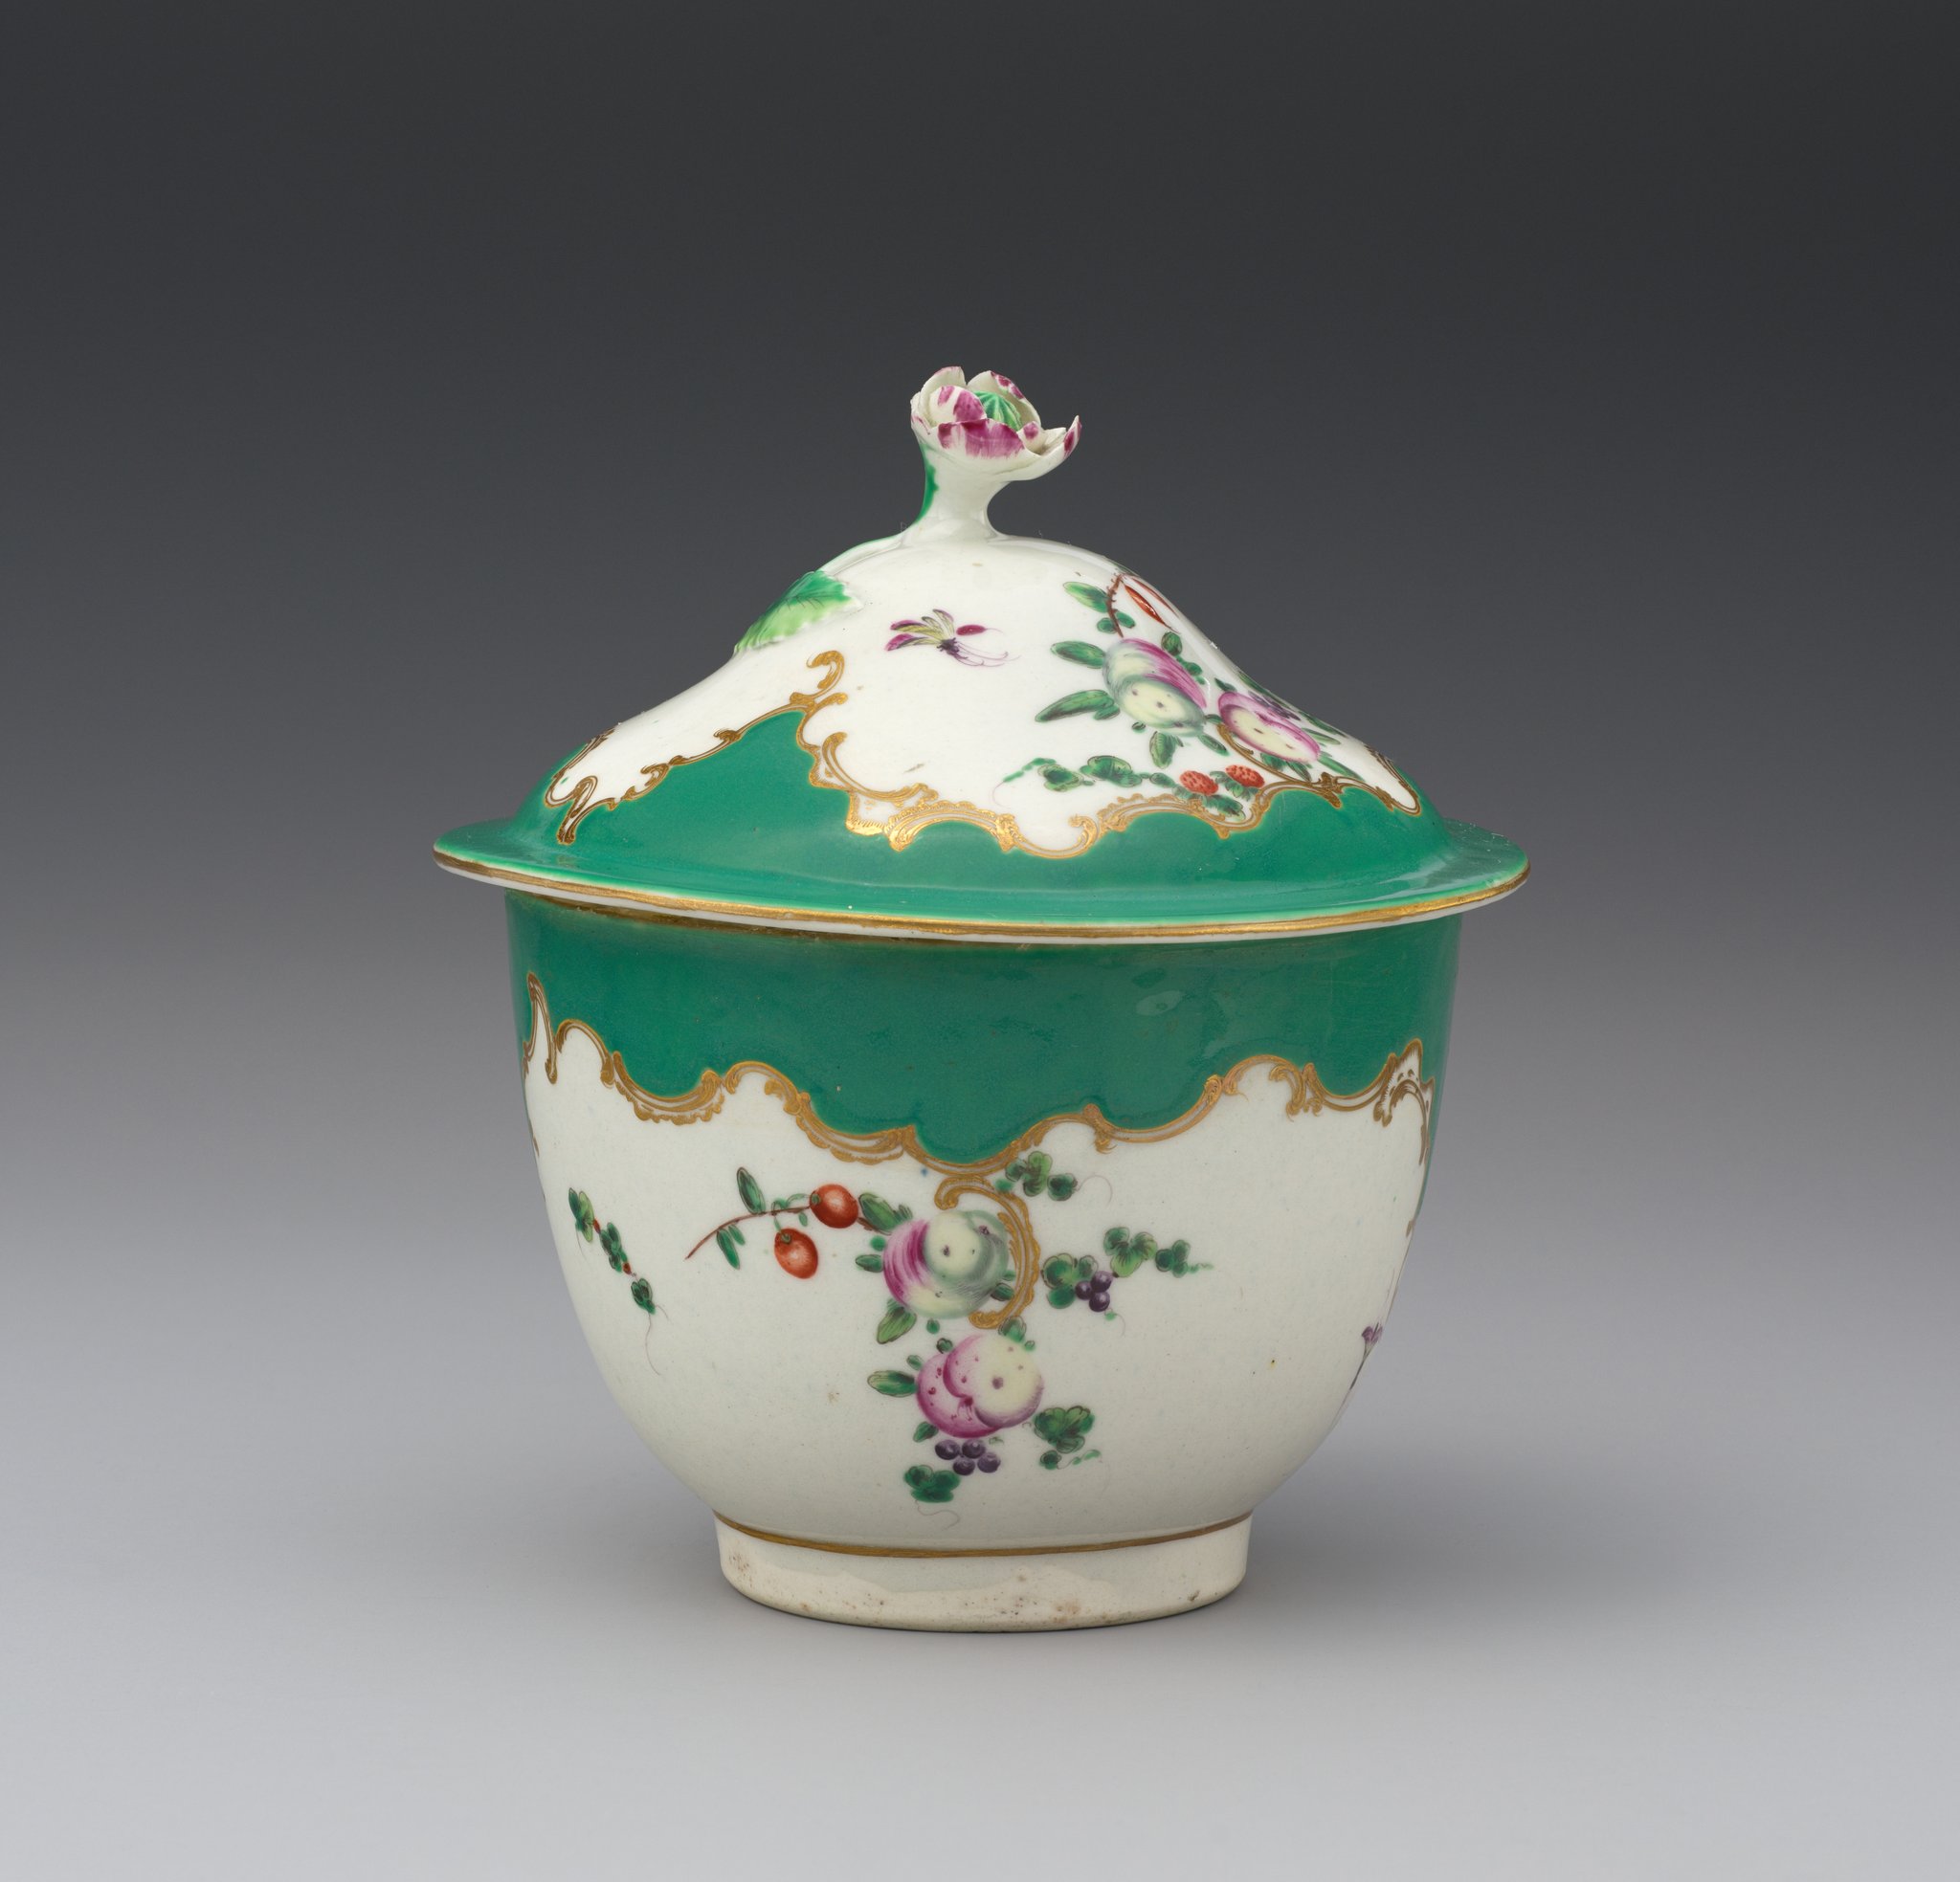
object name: sugar bowl with cover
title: Sugar bowl with cover (part of a service)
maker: worcester factory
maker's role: factory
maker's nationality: british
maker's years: 1751-2008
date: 1770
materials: soft paste porcelain